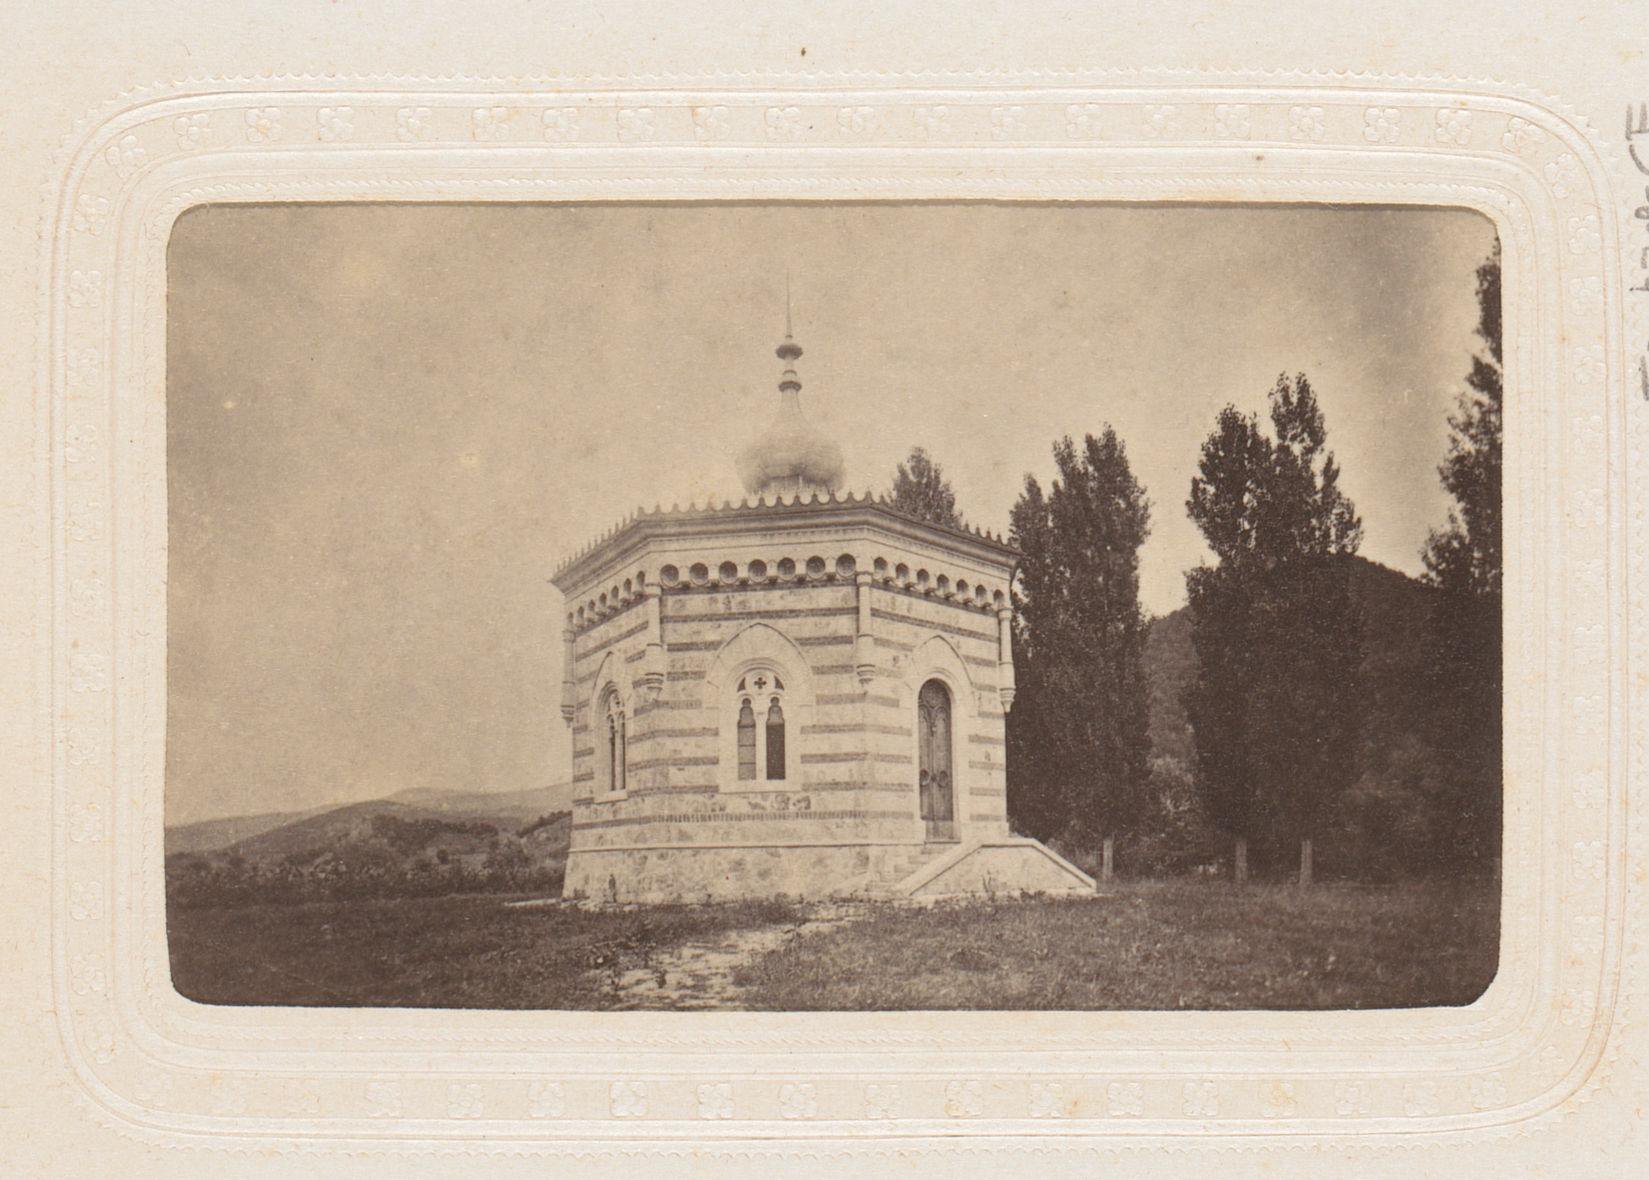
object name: photograph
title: Gezicht op een kapel te Băile Herculane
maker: carl händl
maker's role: fotograaf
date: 1860-1880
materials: cardboard, photographic support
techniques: albumen print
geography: băile herculane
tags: parts of church exterior and annexes: chapel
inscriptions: annotation: ‘Kapelle’, inscription: ‘Herculesbad./ Aufgenommen von Carl Händl, Photograph’, annotation: ‘Kappelle der ungarische KronungsKleinodien bei Onsova’